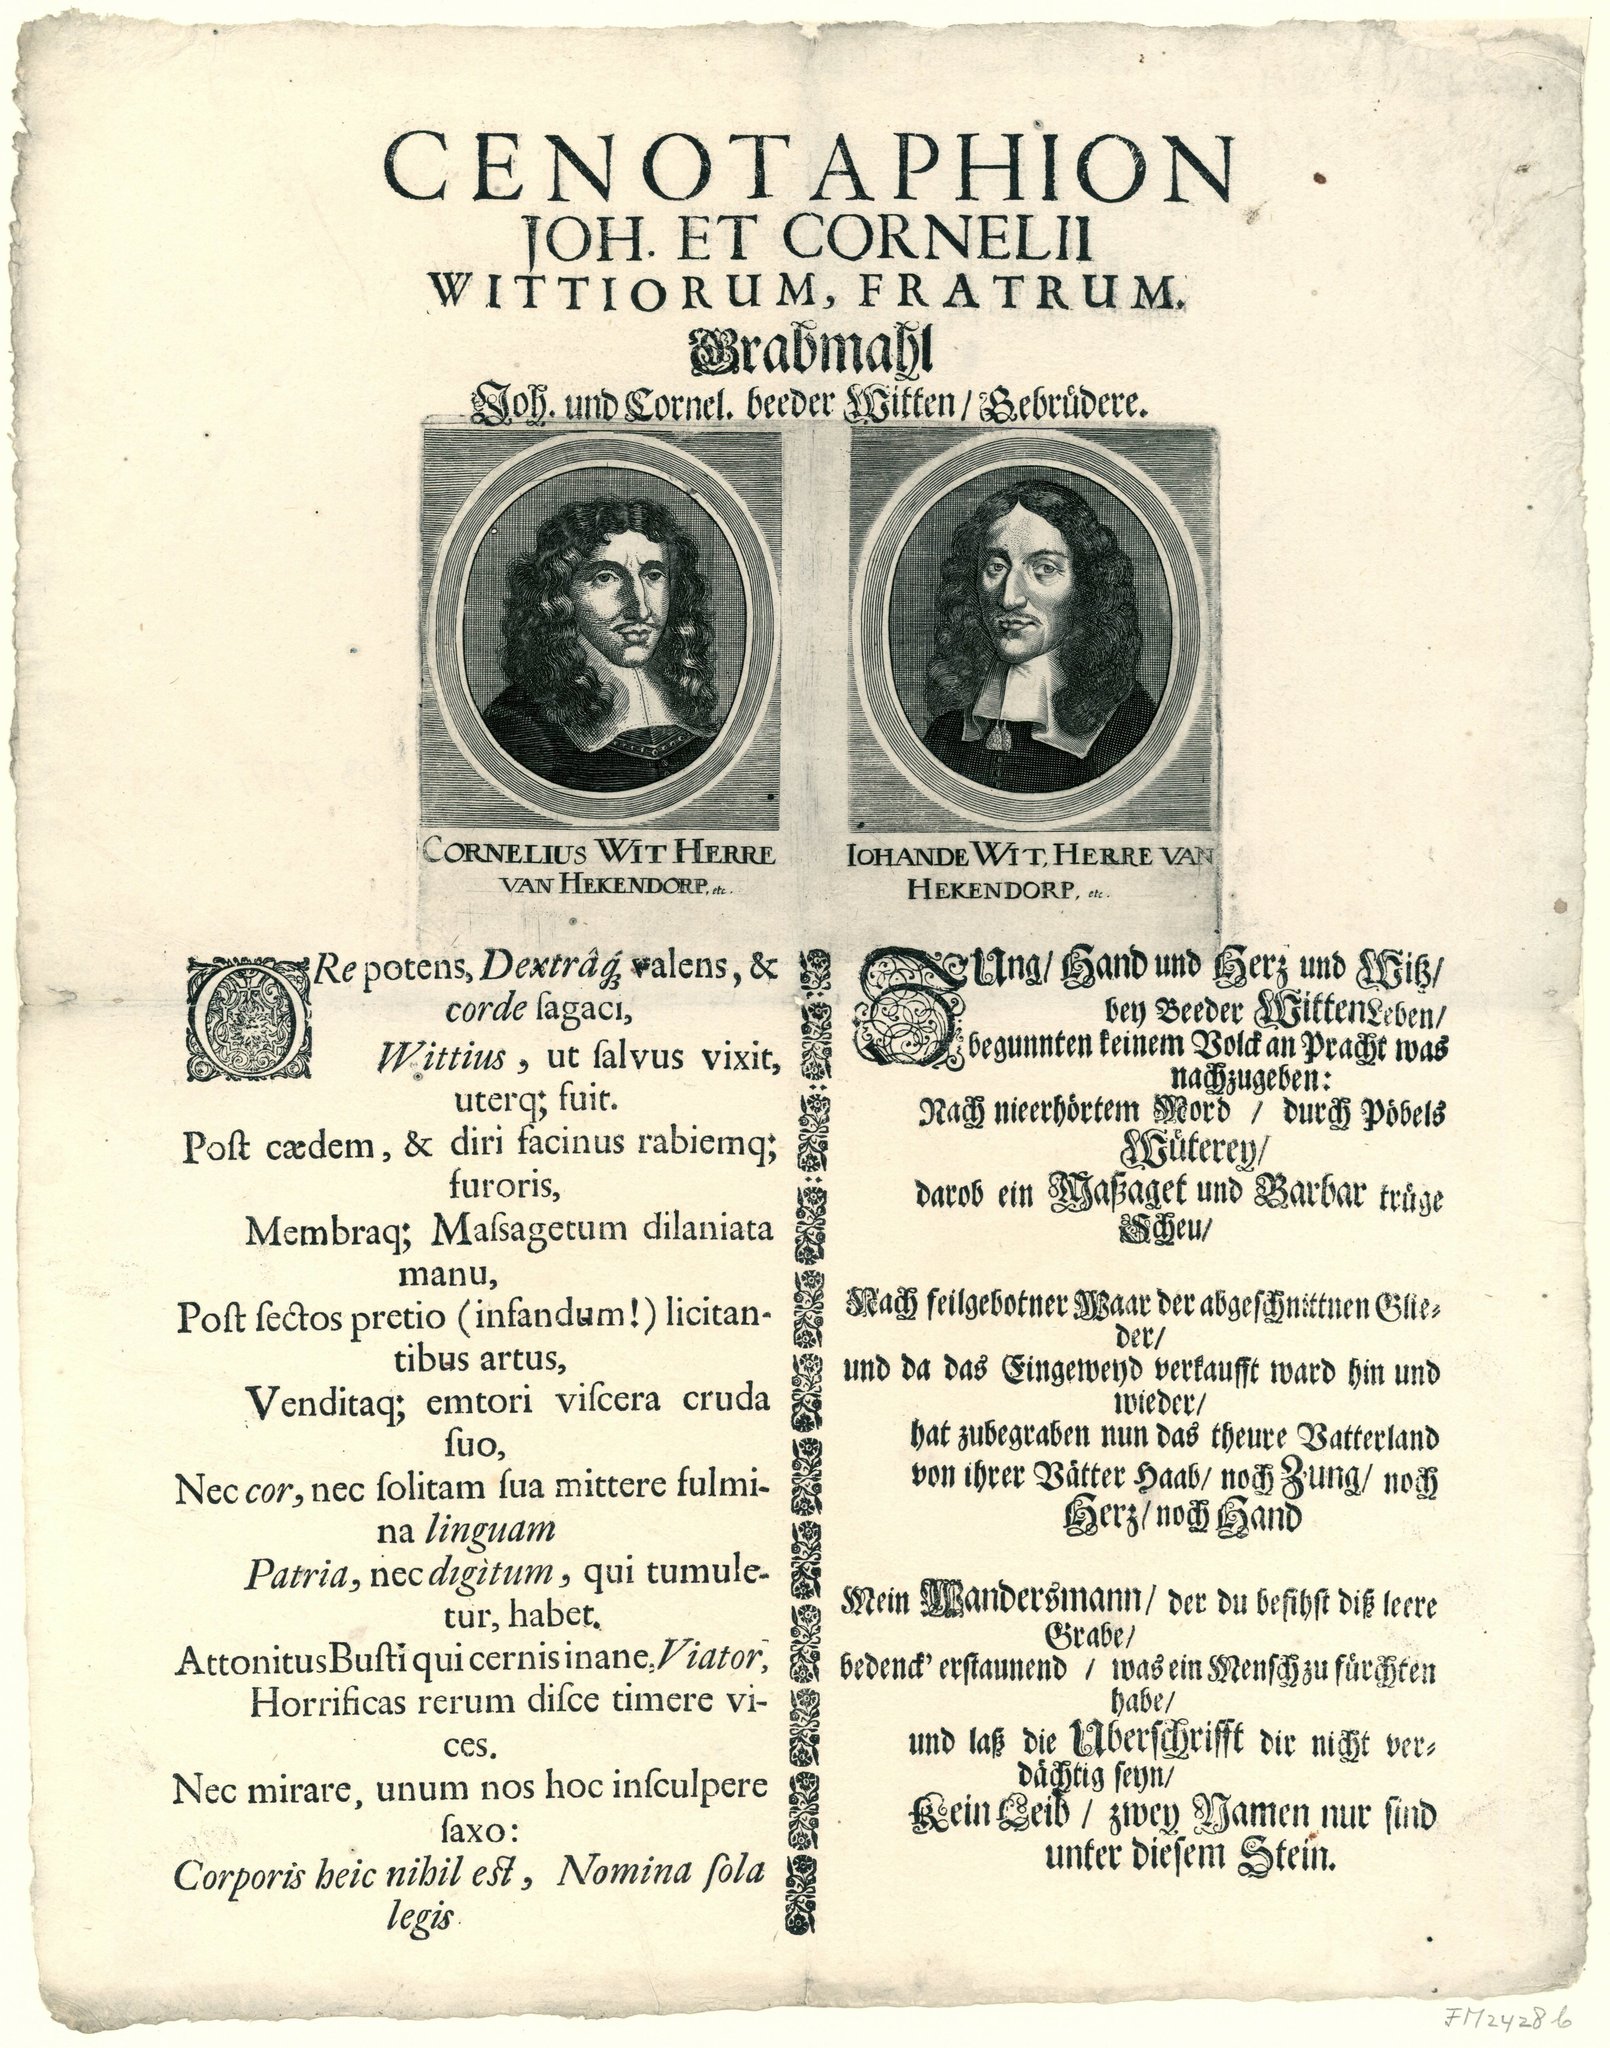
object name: print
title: Cenotaphion Joh. et Cornelii Wittiorum, Fratrum. Grabmahl Joh. und Cornel. beeder Witten / Gebrüdere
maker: Anonymous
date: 1672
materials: paper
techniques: engraving, etching, letterpress printing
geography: germany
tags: dordrecht, cornelis de witt, the hague, politician, johan de witt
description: Duits blad met portretten van en verzen over Johan en Cornelis de Witt. Bovenaan twee eenvoudige portretten, links 'Cornelius Wit Herre van Hekendorp etc', rechts 'Johan de Wit, Herre van Hekendorp etc'. Hieronder twee verzen in het Latijn en Duits.